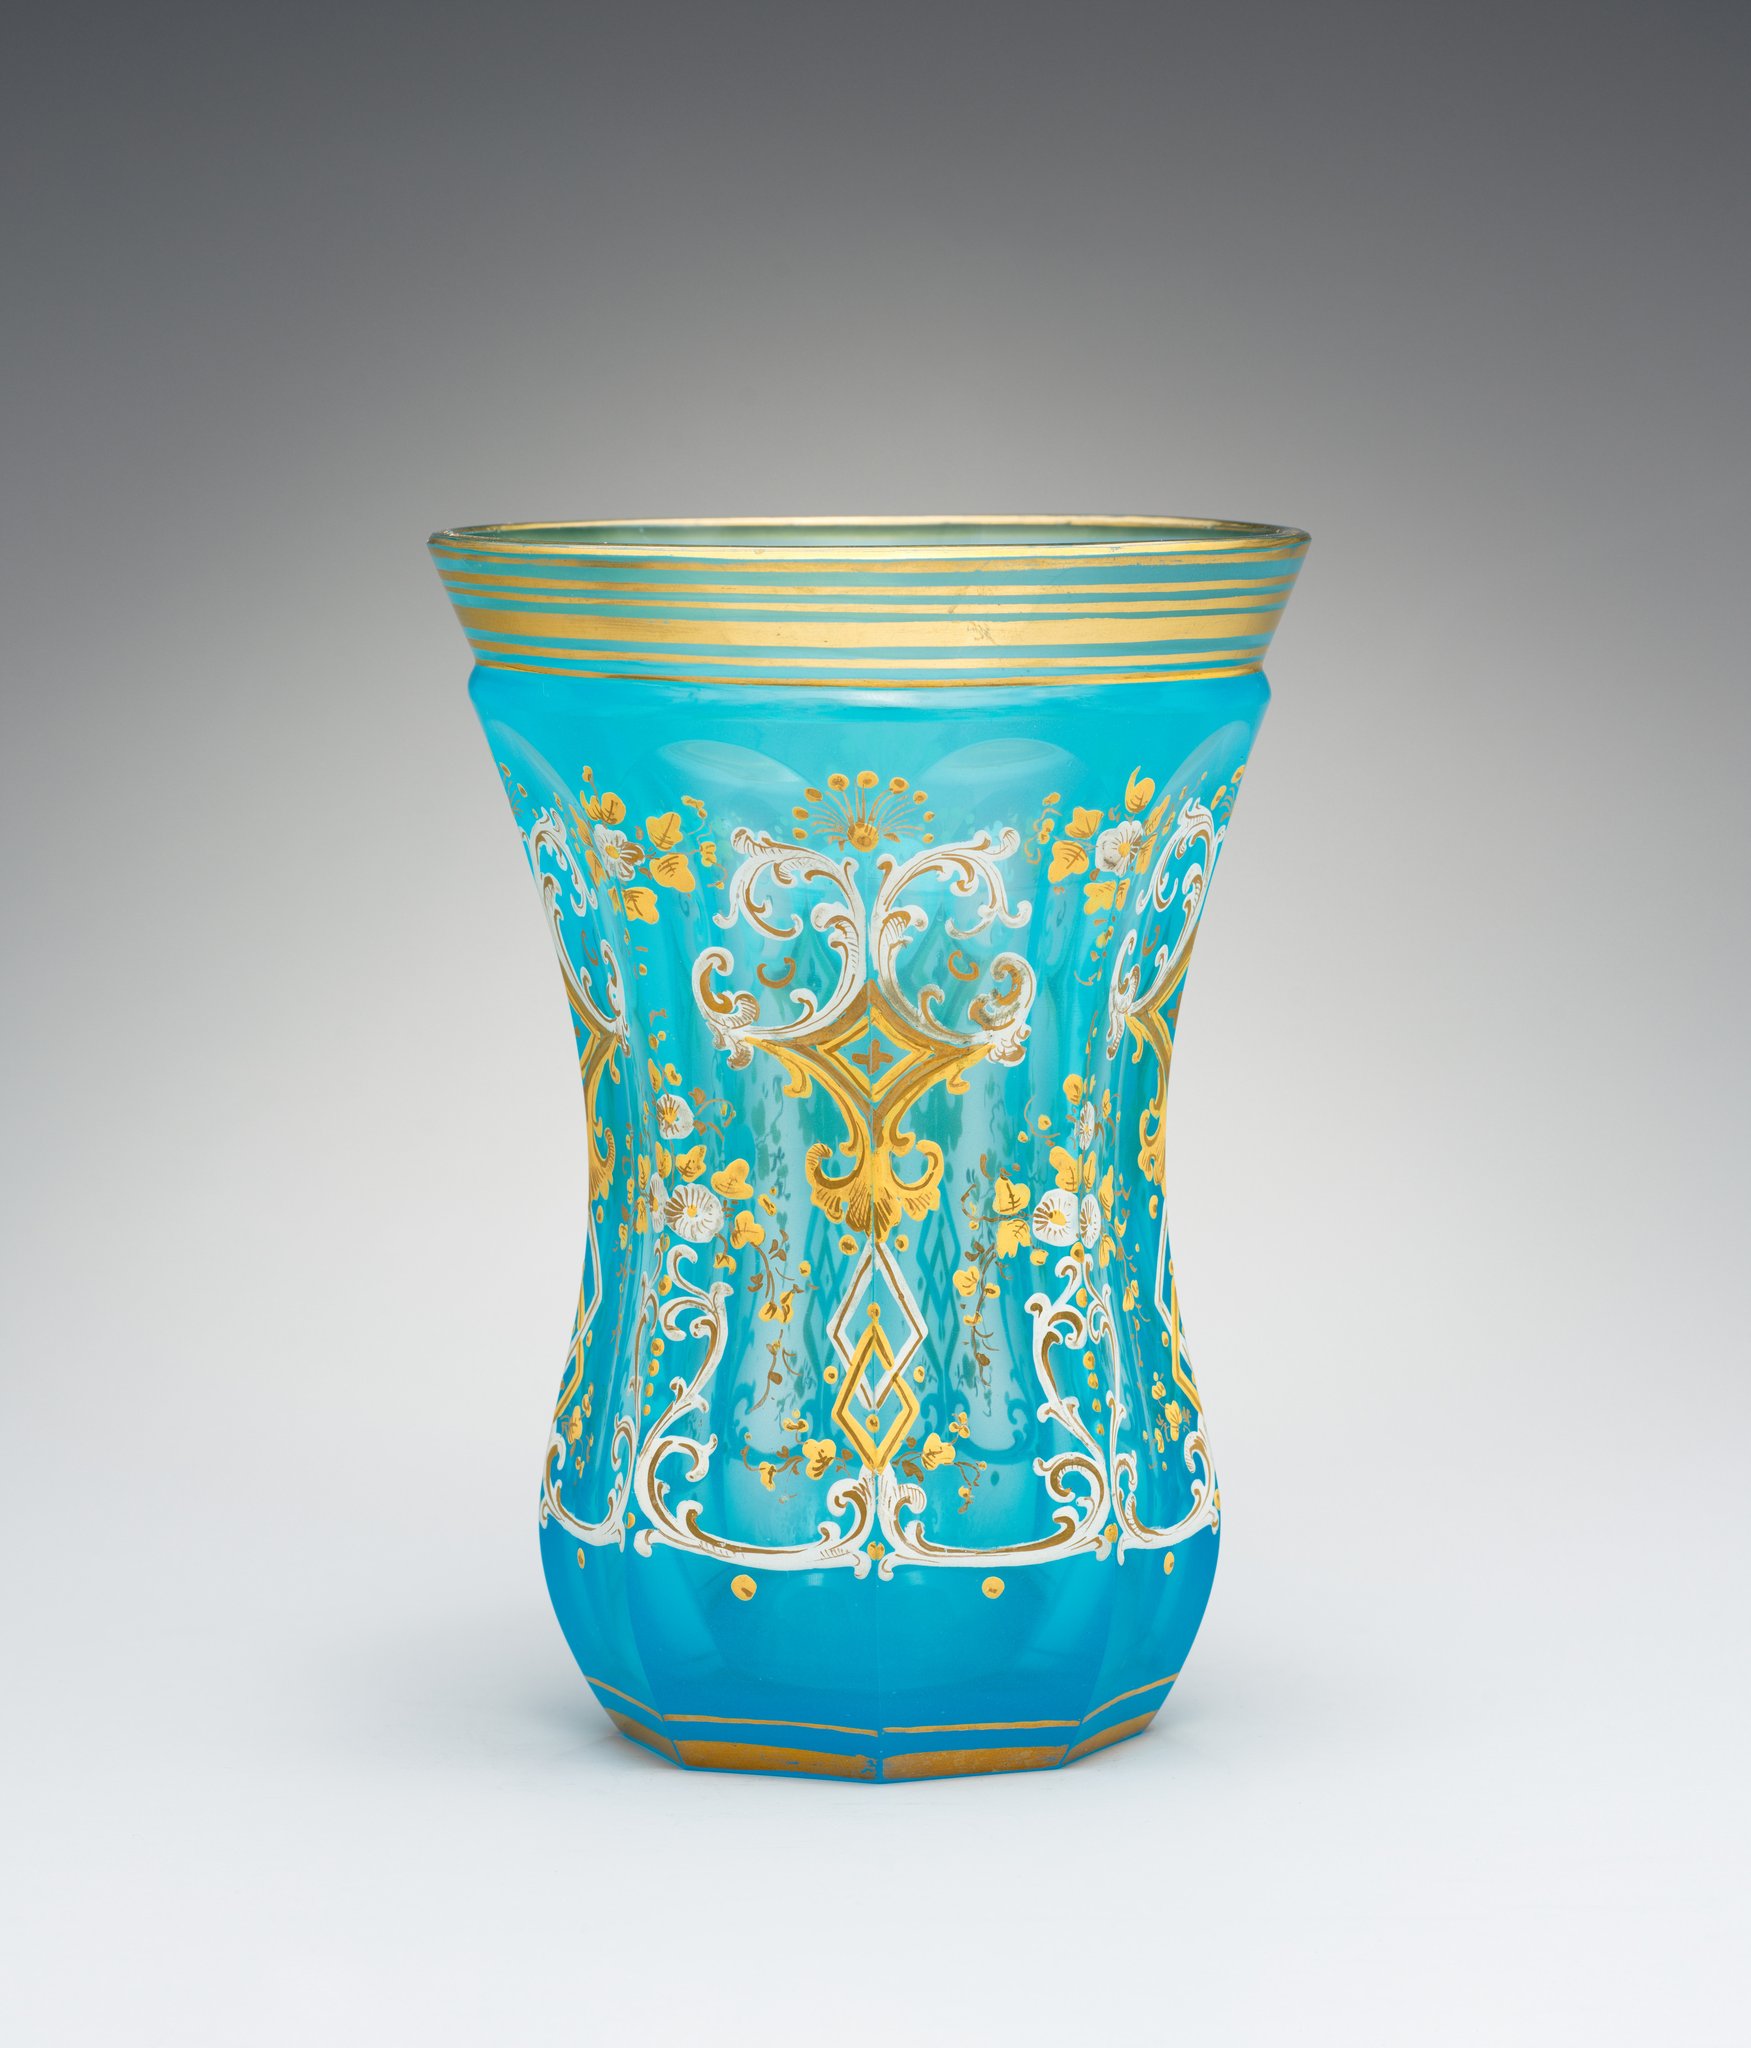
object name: beaker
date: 1830-1840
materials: glass